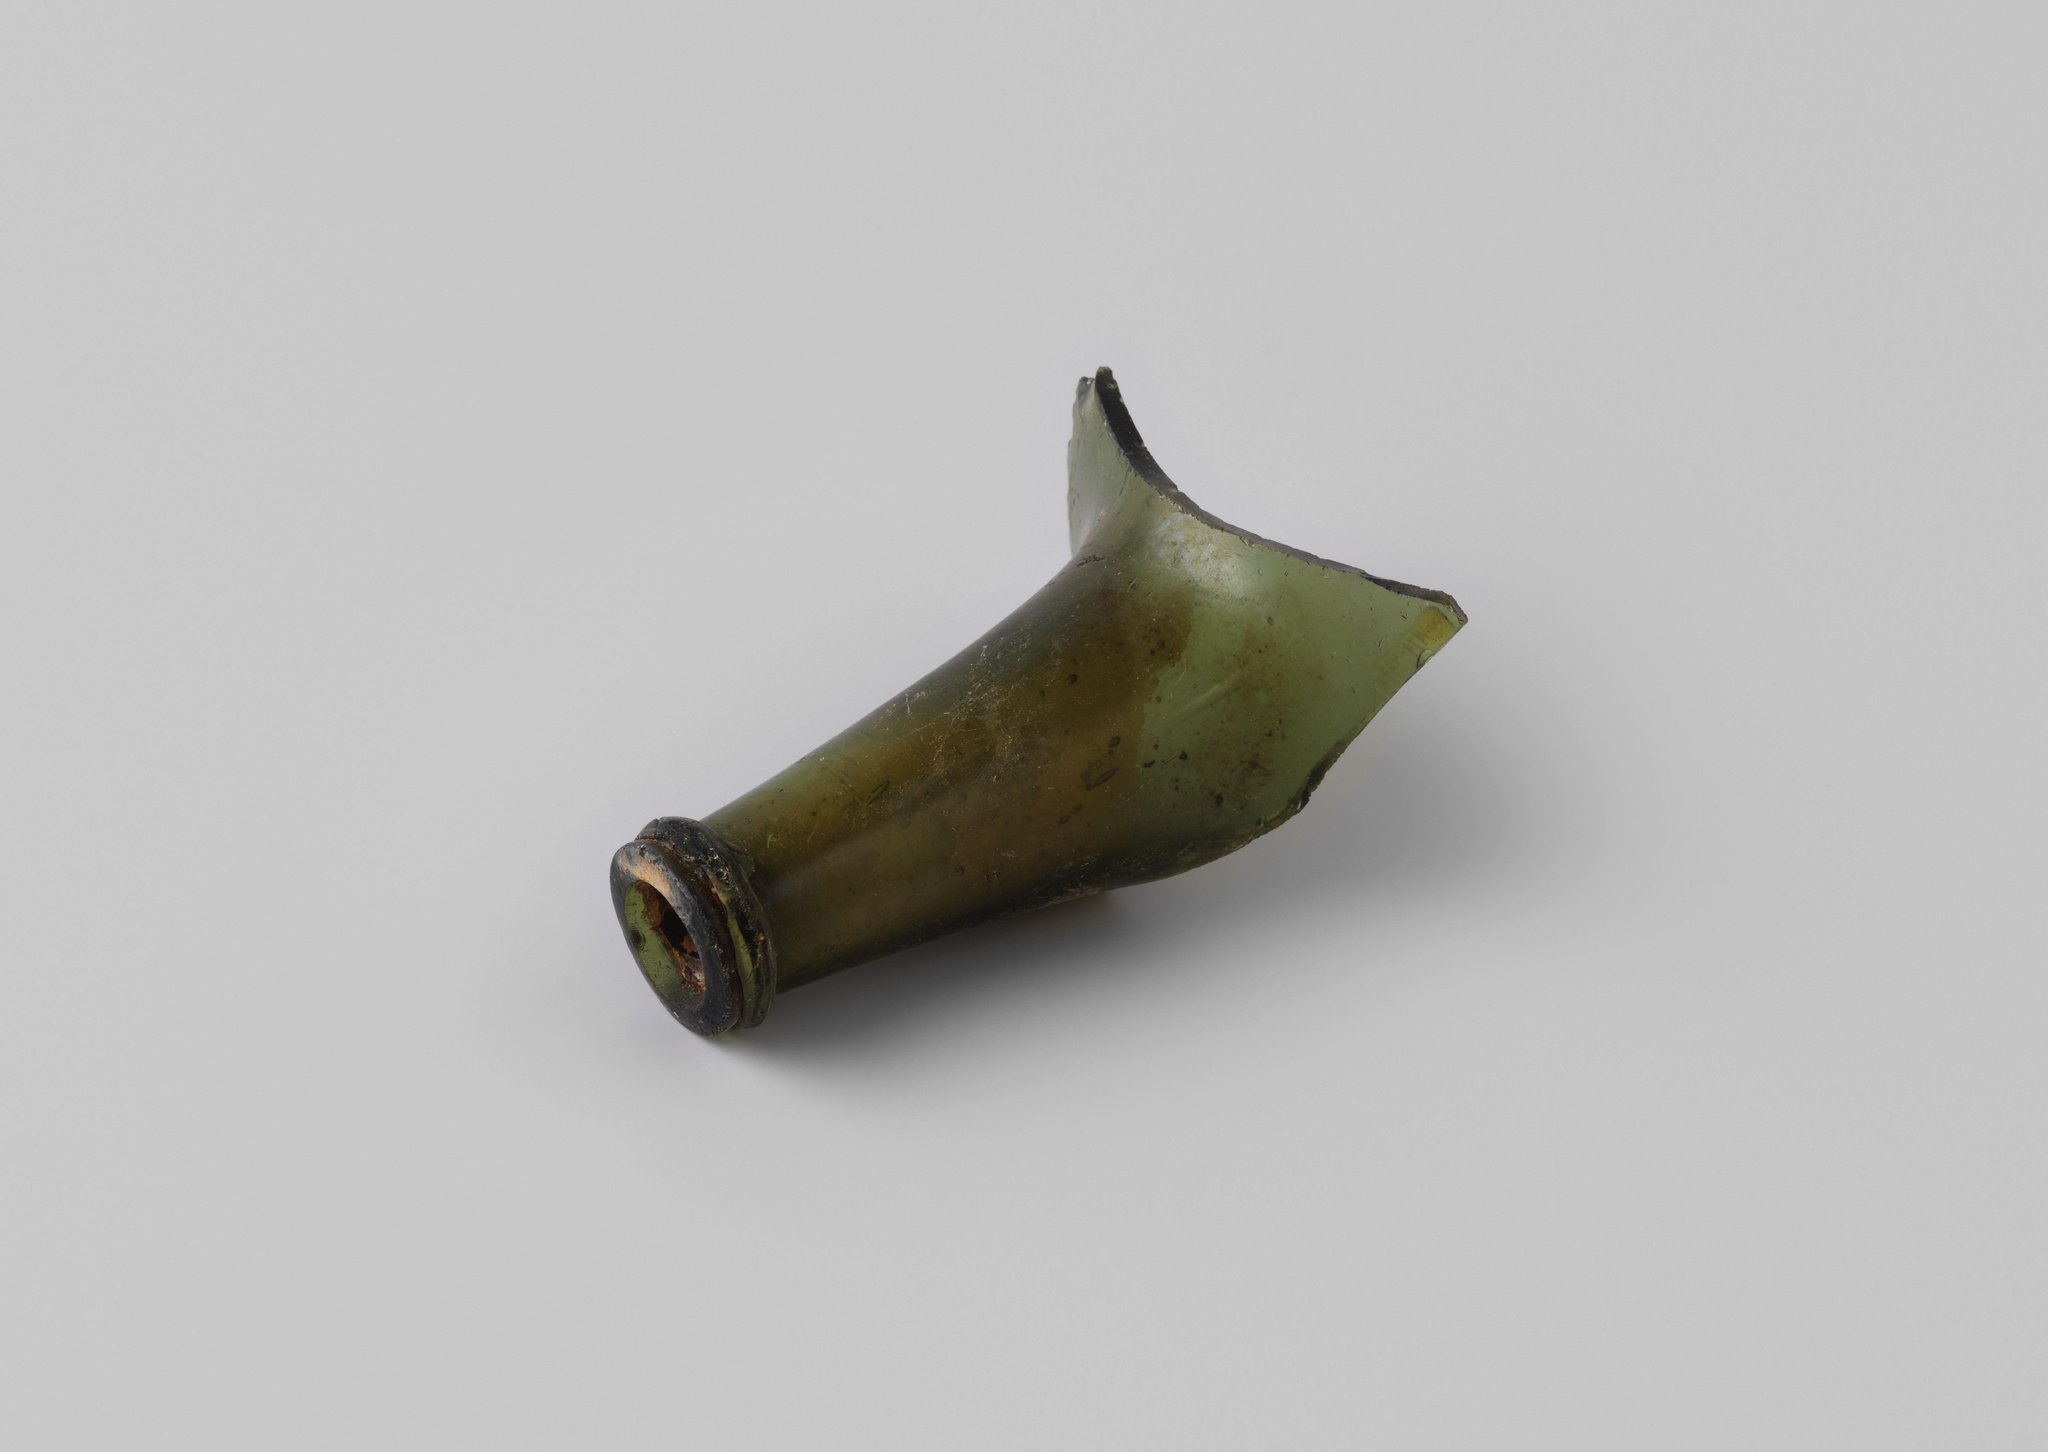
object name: wine bottle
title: Hals van een wijnfles uit het wrak van de Oost-Indiëvaarder Hollandia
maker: Anonymous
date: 1700-1743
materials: glass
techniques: green glass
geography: netherlands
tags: verenigde oostindische compagnie, hollandia (schip), annet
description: Wine bottle, continental production, neck, onion-shaped bottle or bottle with vertical side; vs-string rim.